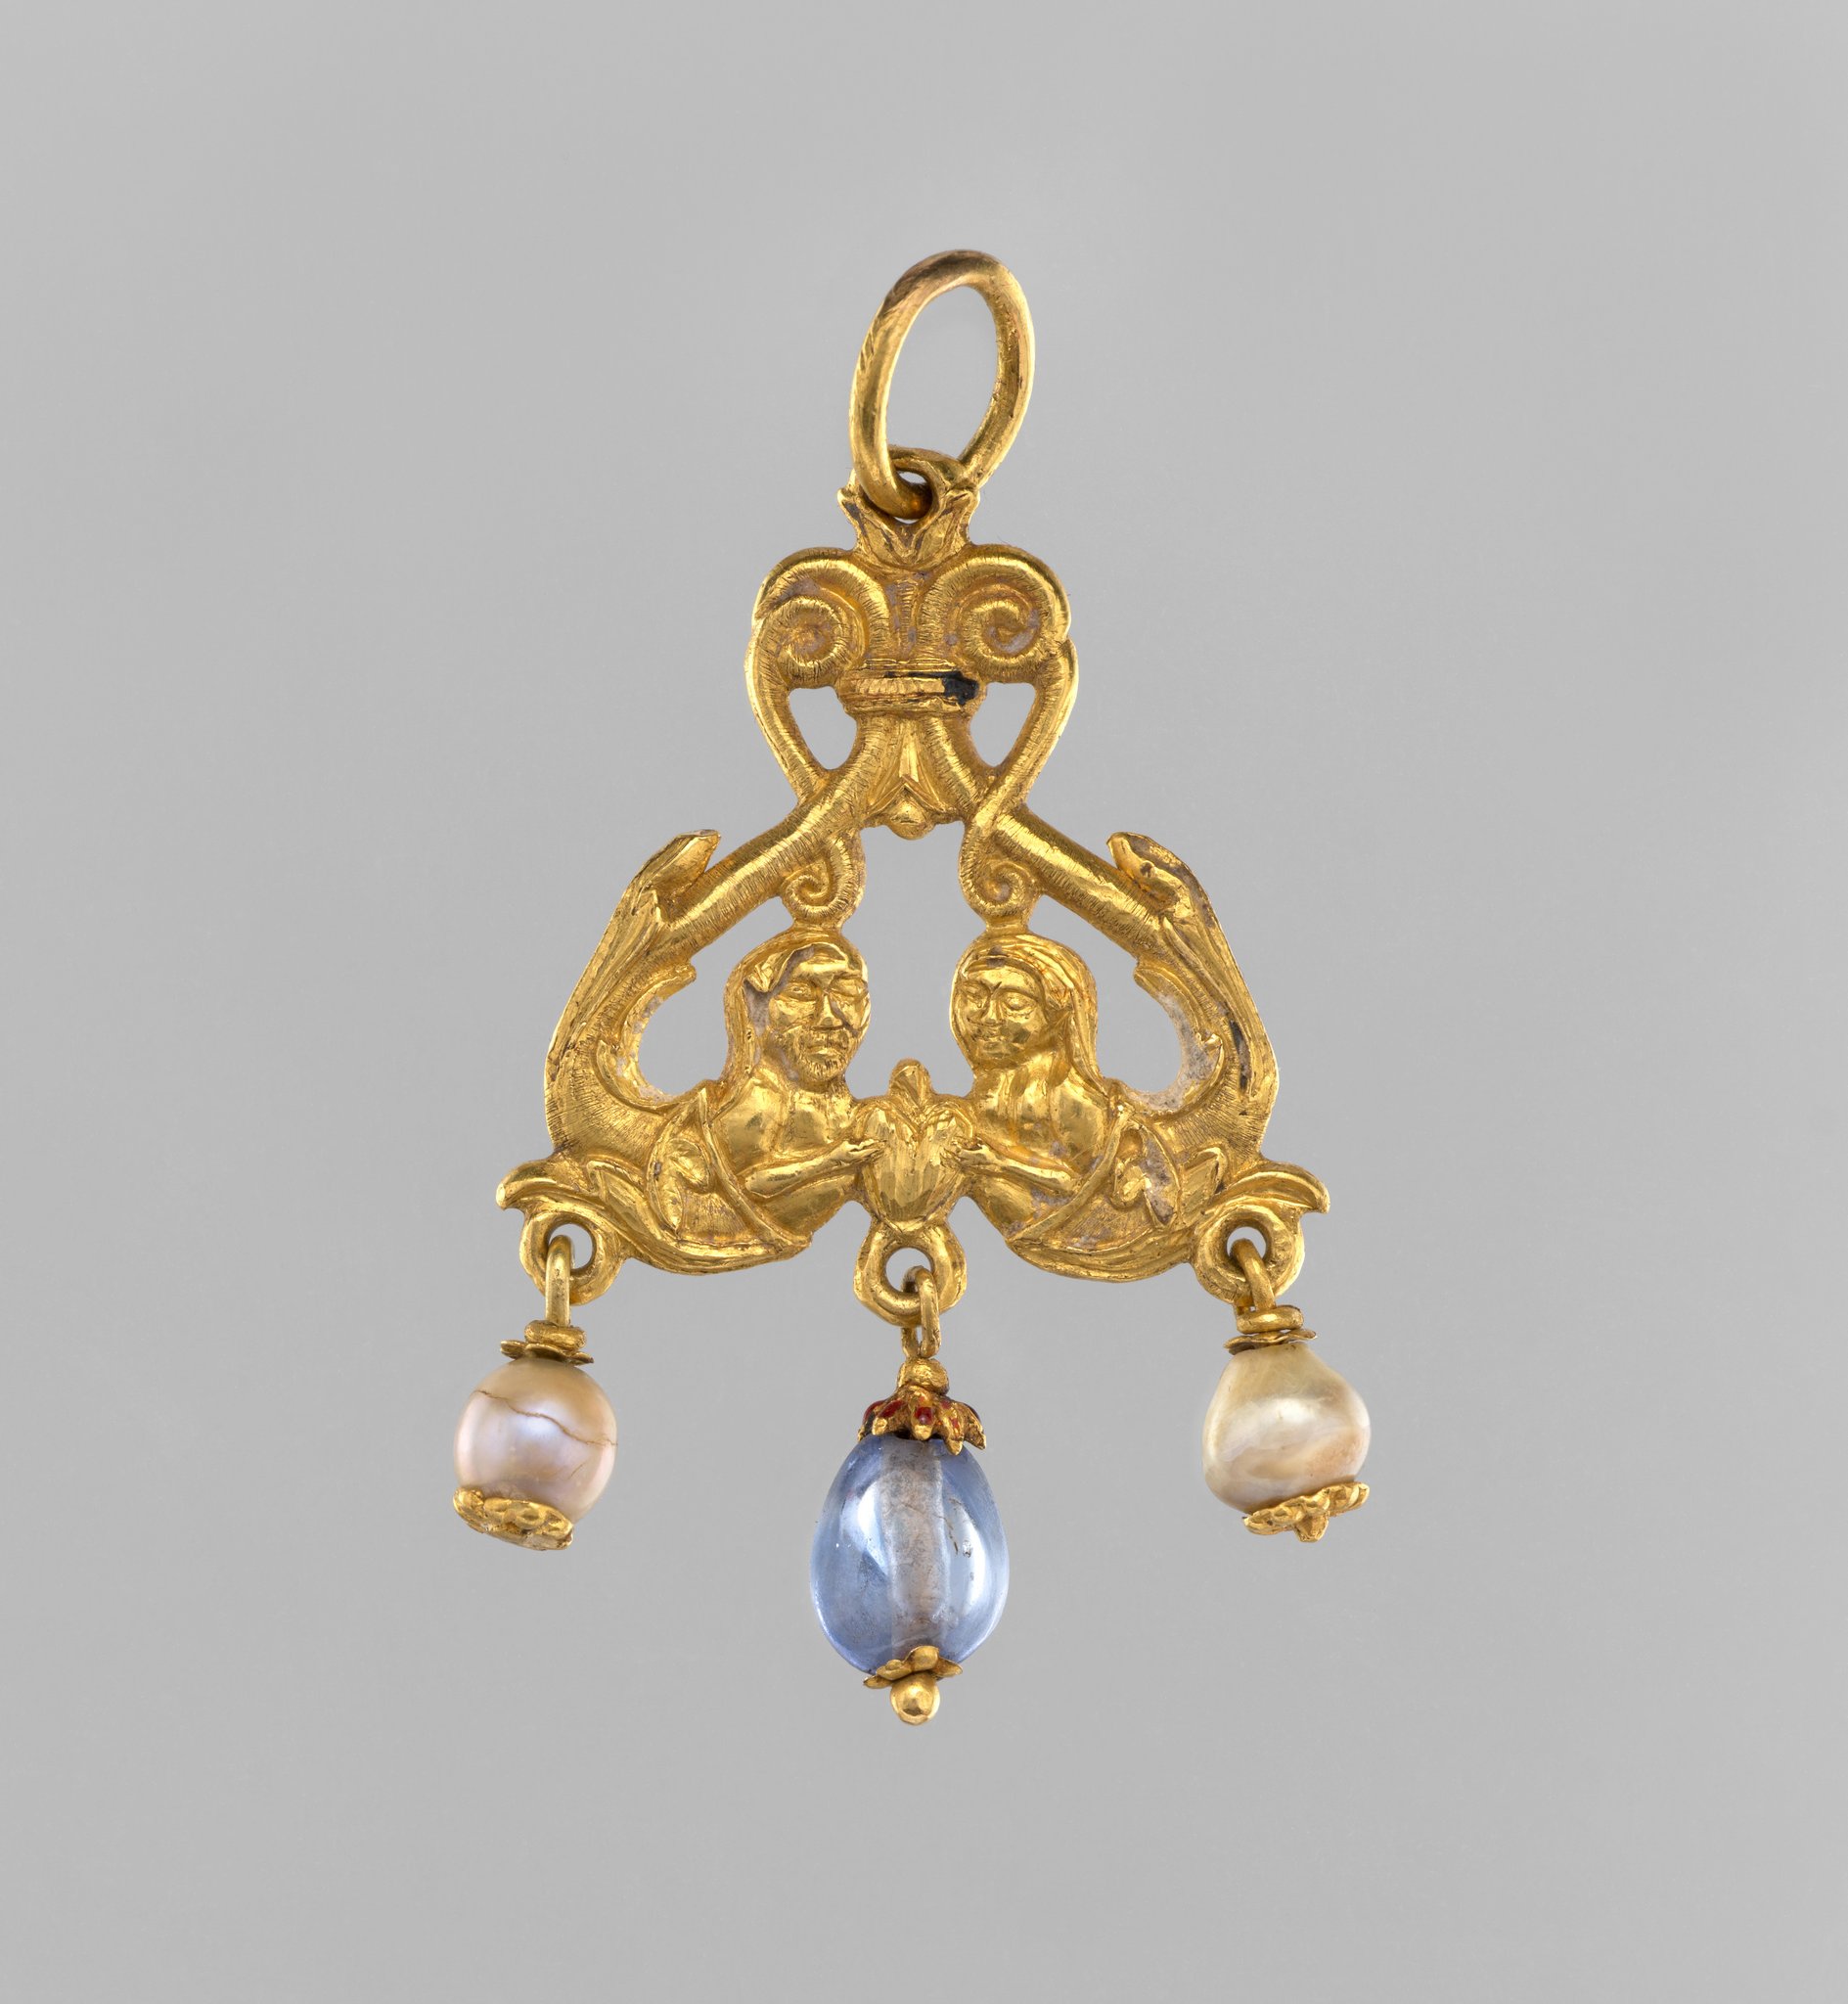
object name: pendant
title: Sixteenth-century-style pendant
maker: albrecht dürer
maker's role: maker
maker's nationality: german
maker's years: 1471-1528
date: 1801-1900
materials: enamel, gold, pearl, gemstone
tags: mermaids